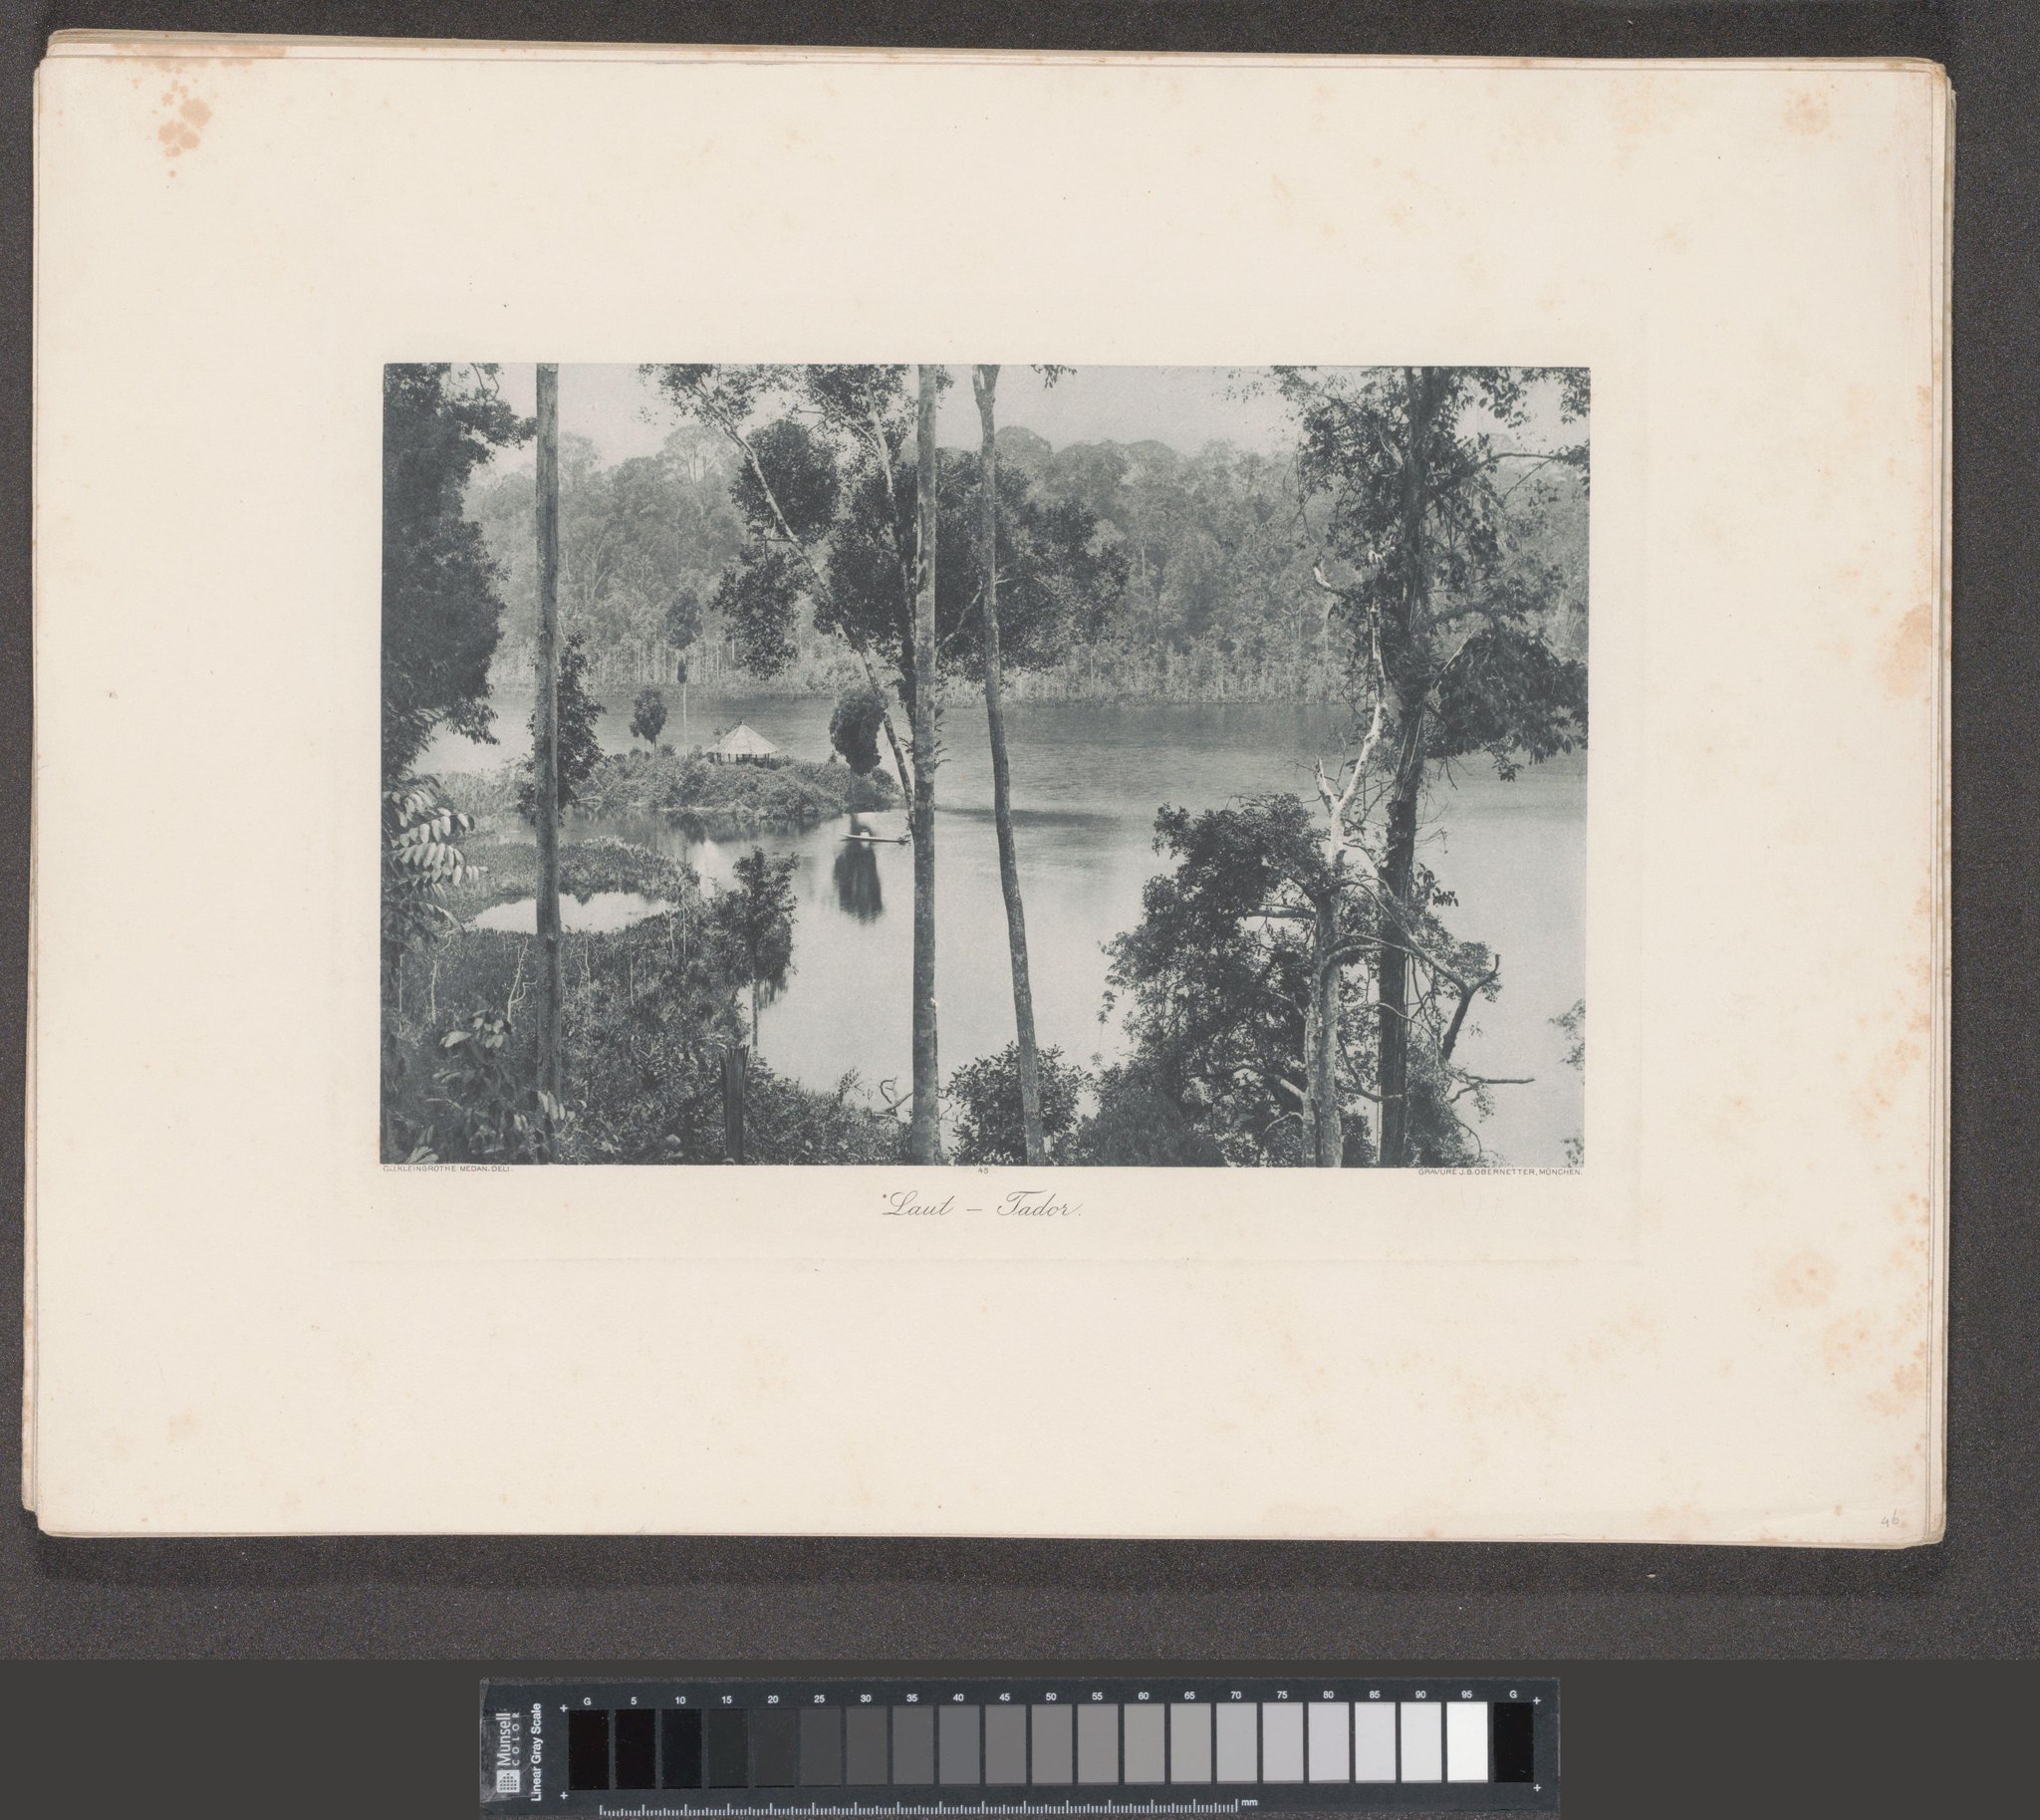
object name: photomechanical print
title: Gezicht op een rivier met uitspanning te Laut Tador op Sumatra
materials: paper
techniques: photoaquatint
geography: munich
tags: river, sumatra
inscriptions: number: ‘45’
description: Onderdeel van Album met heliogravures van Sumatra's oostkust.